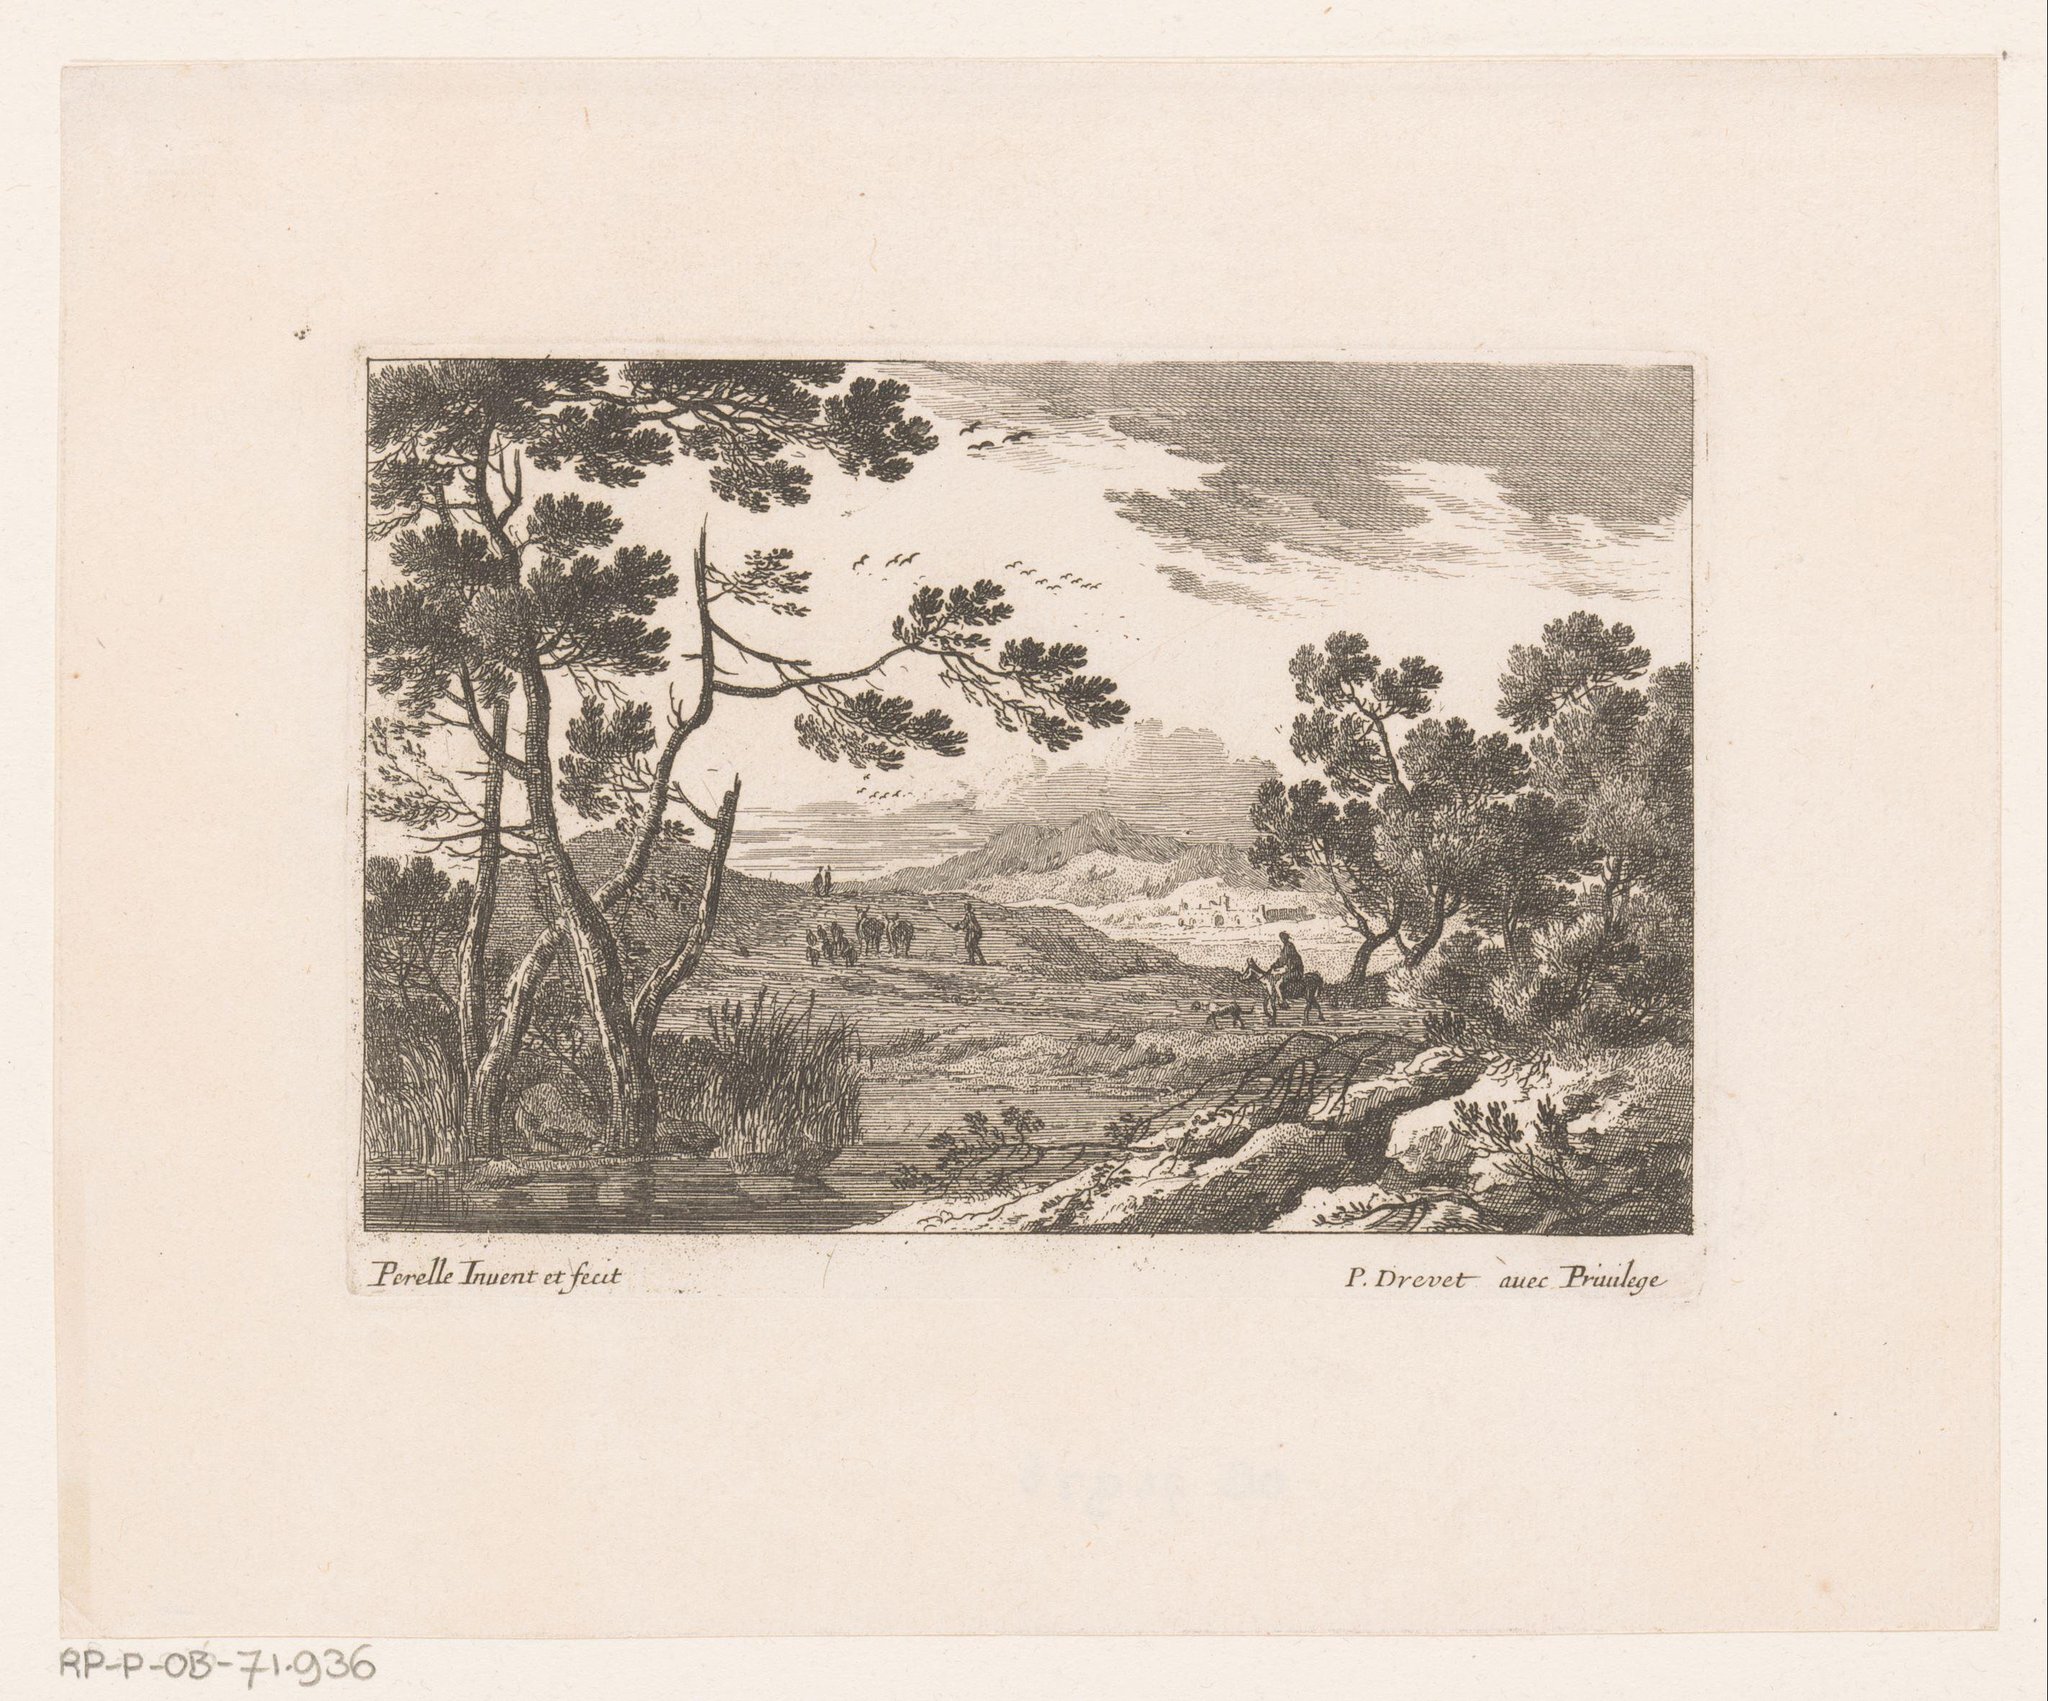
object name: print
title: Landschap met man die kudde voortdrijft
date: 1673-1695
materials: paper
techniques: etching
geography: france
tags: landscapes, herding, herdsman, herdswoman, shepherd, shepherdess, cowherd, etc.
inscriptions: collector's mark: Lugt 240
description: Prenten met het signatuur 'Perelle' kunnen zowel door vader Gabriel als door zonen Nicolas en Adam gemaakt zijn.